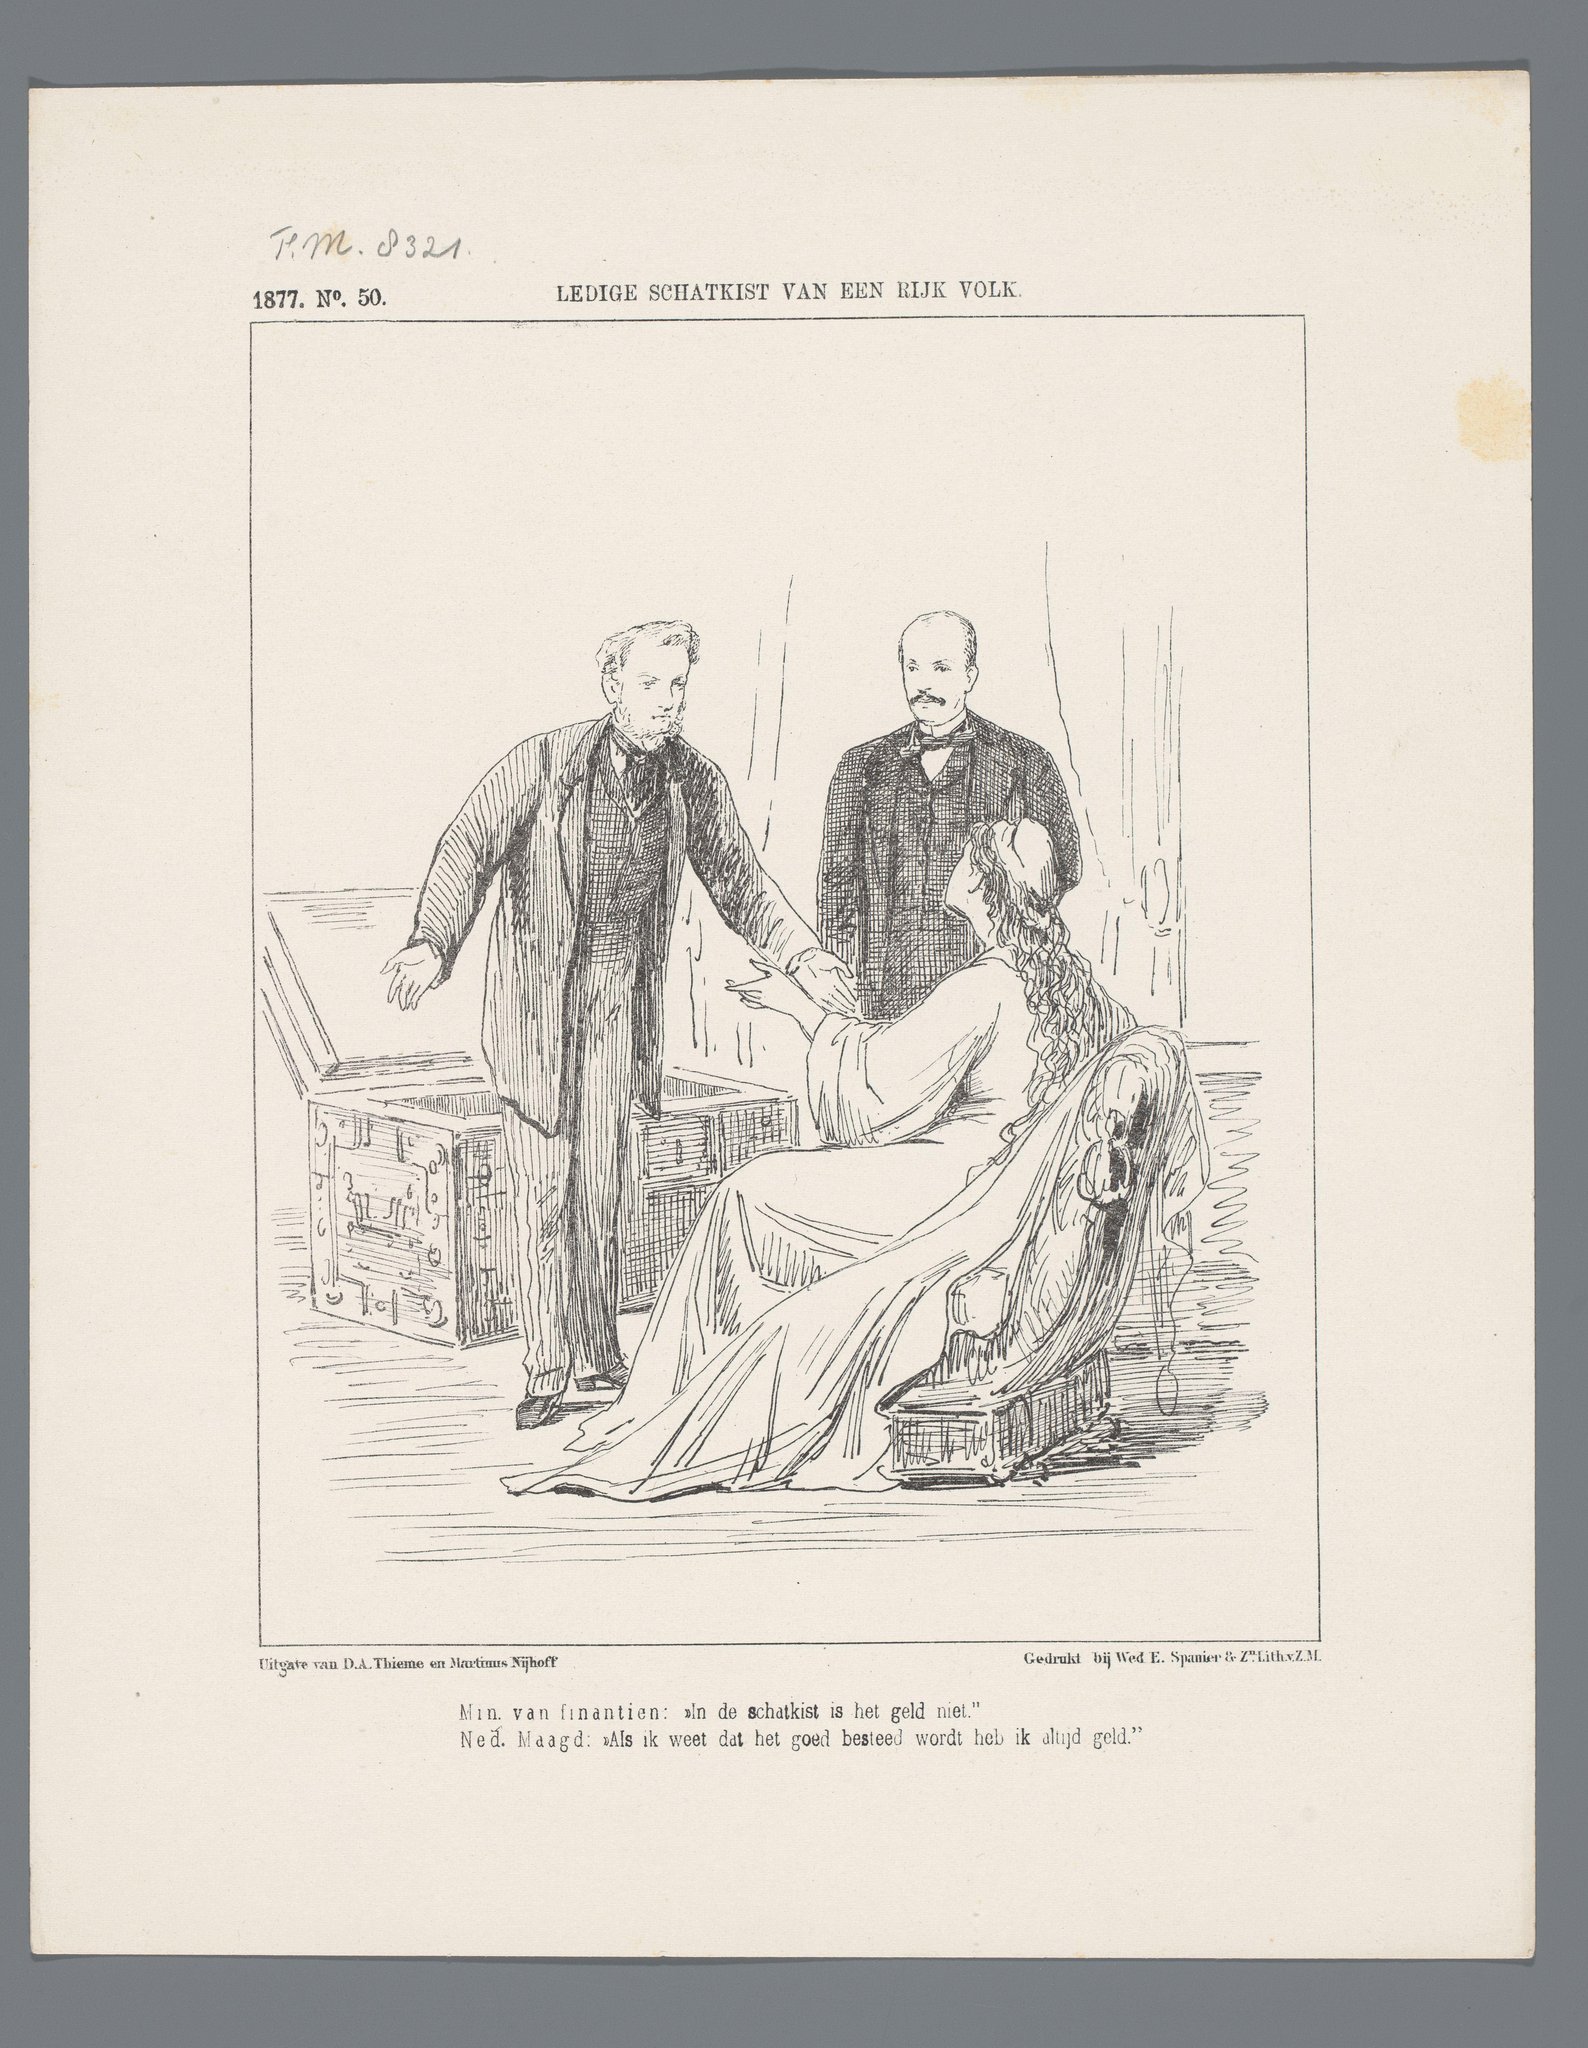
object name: print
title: Ledige schatkist van een rijk volk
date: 1877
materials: paper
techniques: lithograph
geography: netherlands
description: Spotprent. Plaat verschenen bij het weekblad De Nederlandsche Spectator, nr. 50, 1877.